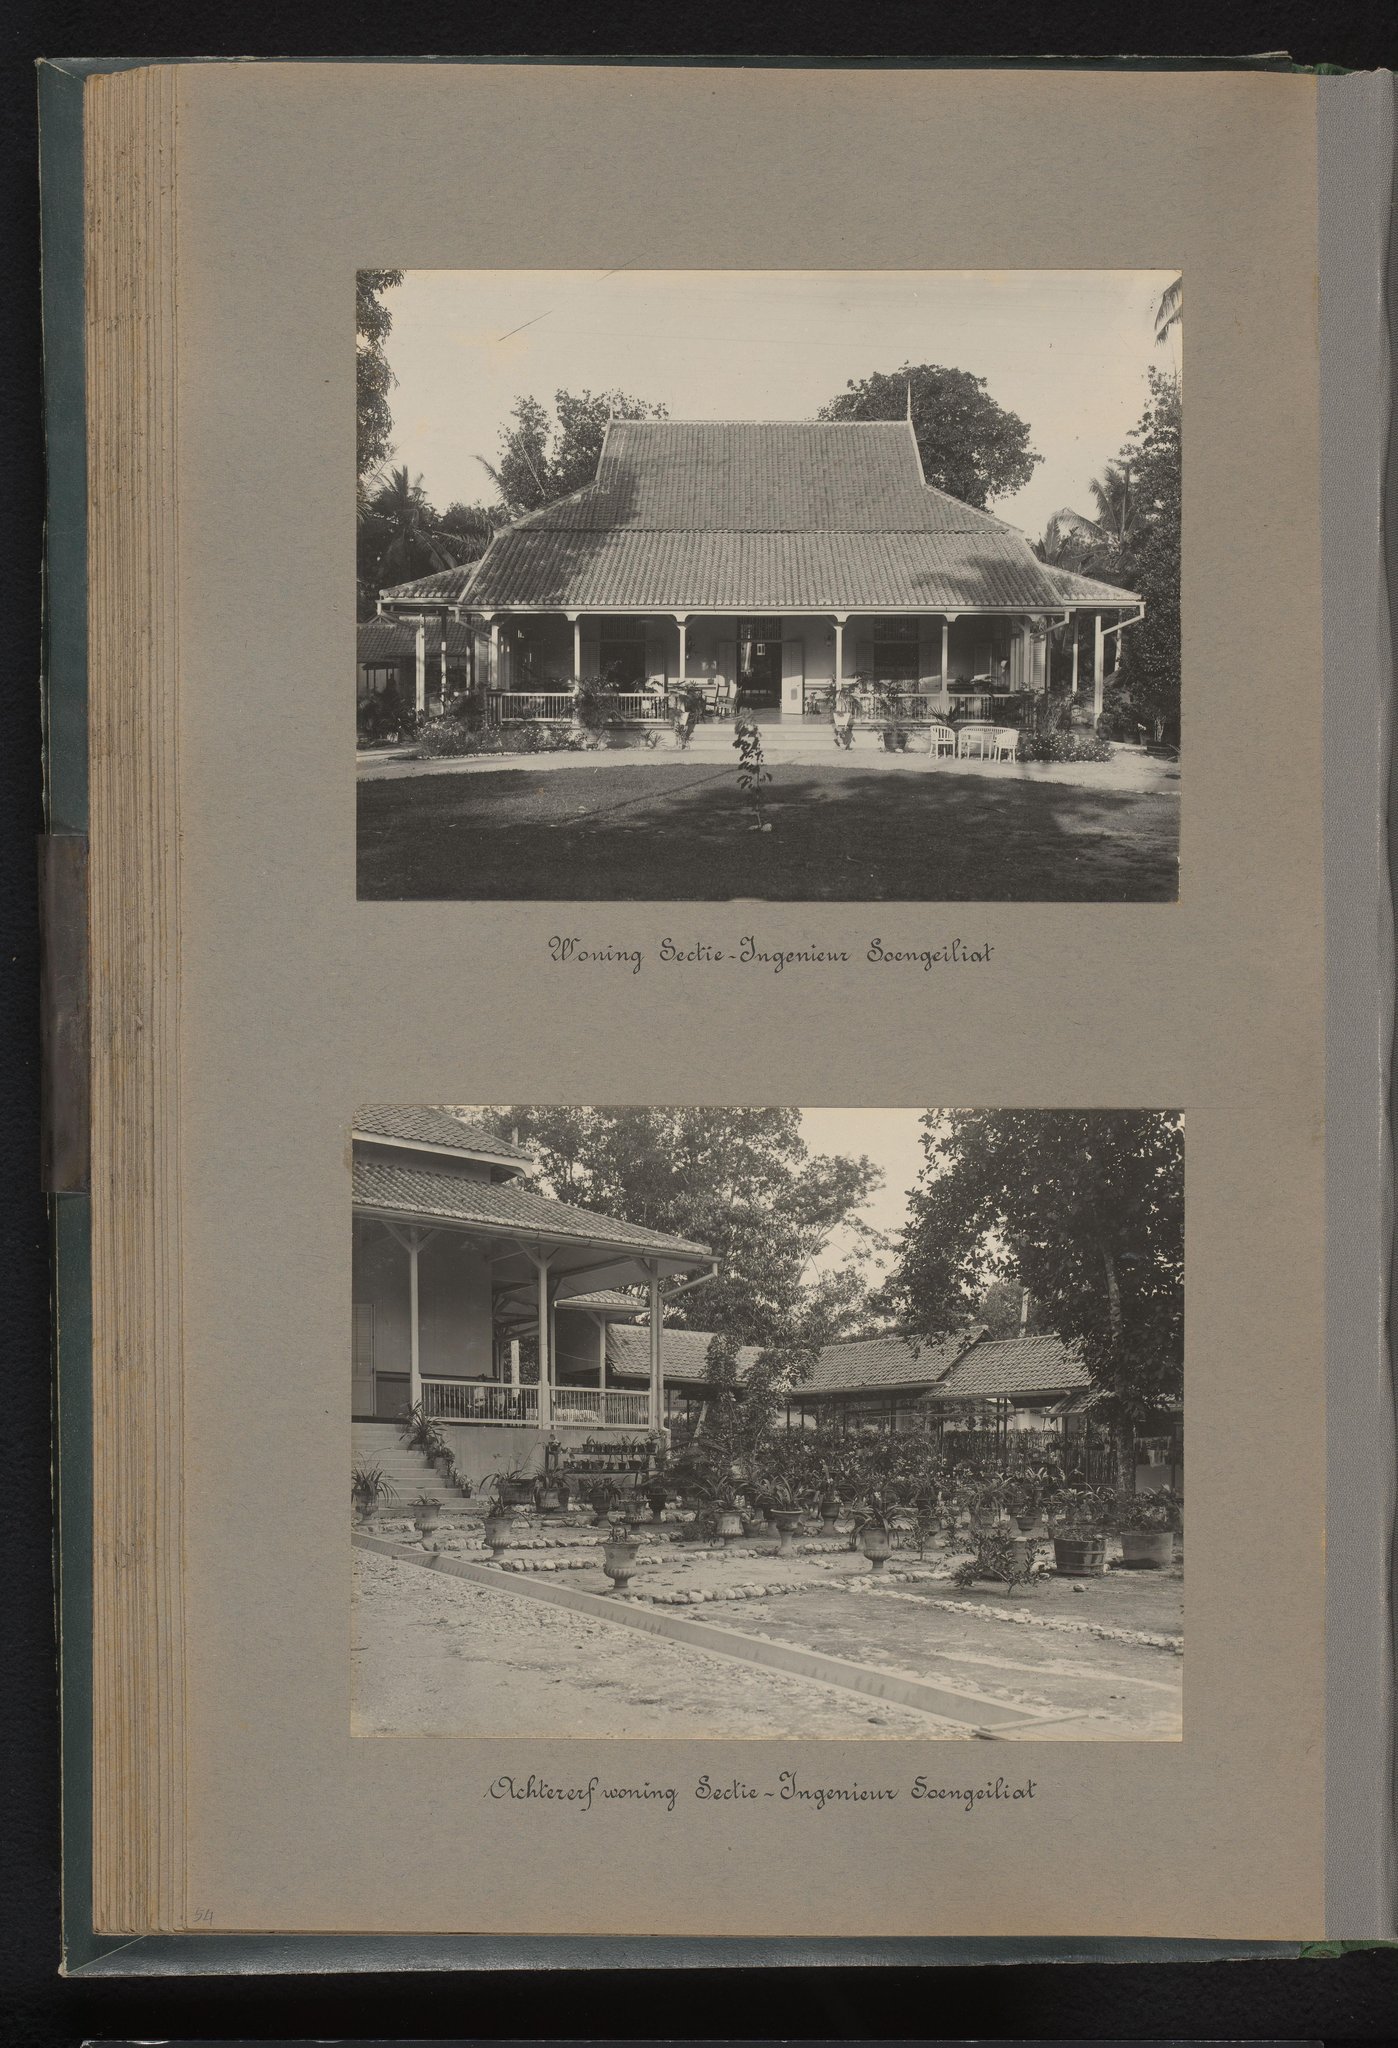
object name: album leaf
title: Gebouwen van de Banka-tinwinning te Soengeiliat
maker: Anonymous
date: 1914-1919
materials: cardboard, photographic support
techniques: gelatin silver print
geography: bangka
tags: robert julius boers, colonial system, mining, villa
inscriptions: inscription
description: Albumblad met 2 foto's van woningen van de ingenieurs van de Banka-tinwinning te Soengeiliat. Onderdeel van het fotoalbum aangeboden aan Robert Julius Boers bij zijn vertrek naar Nederland in 1919 door het personeel van de Banka-tinwinning.